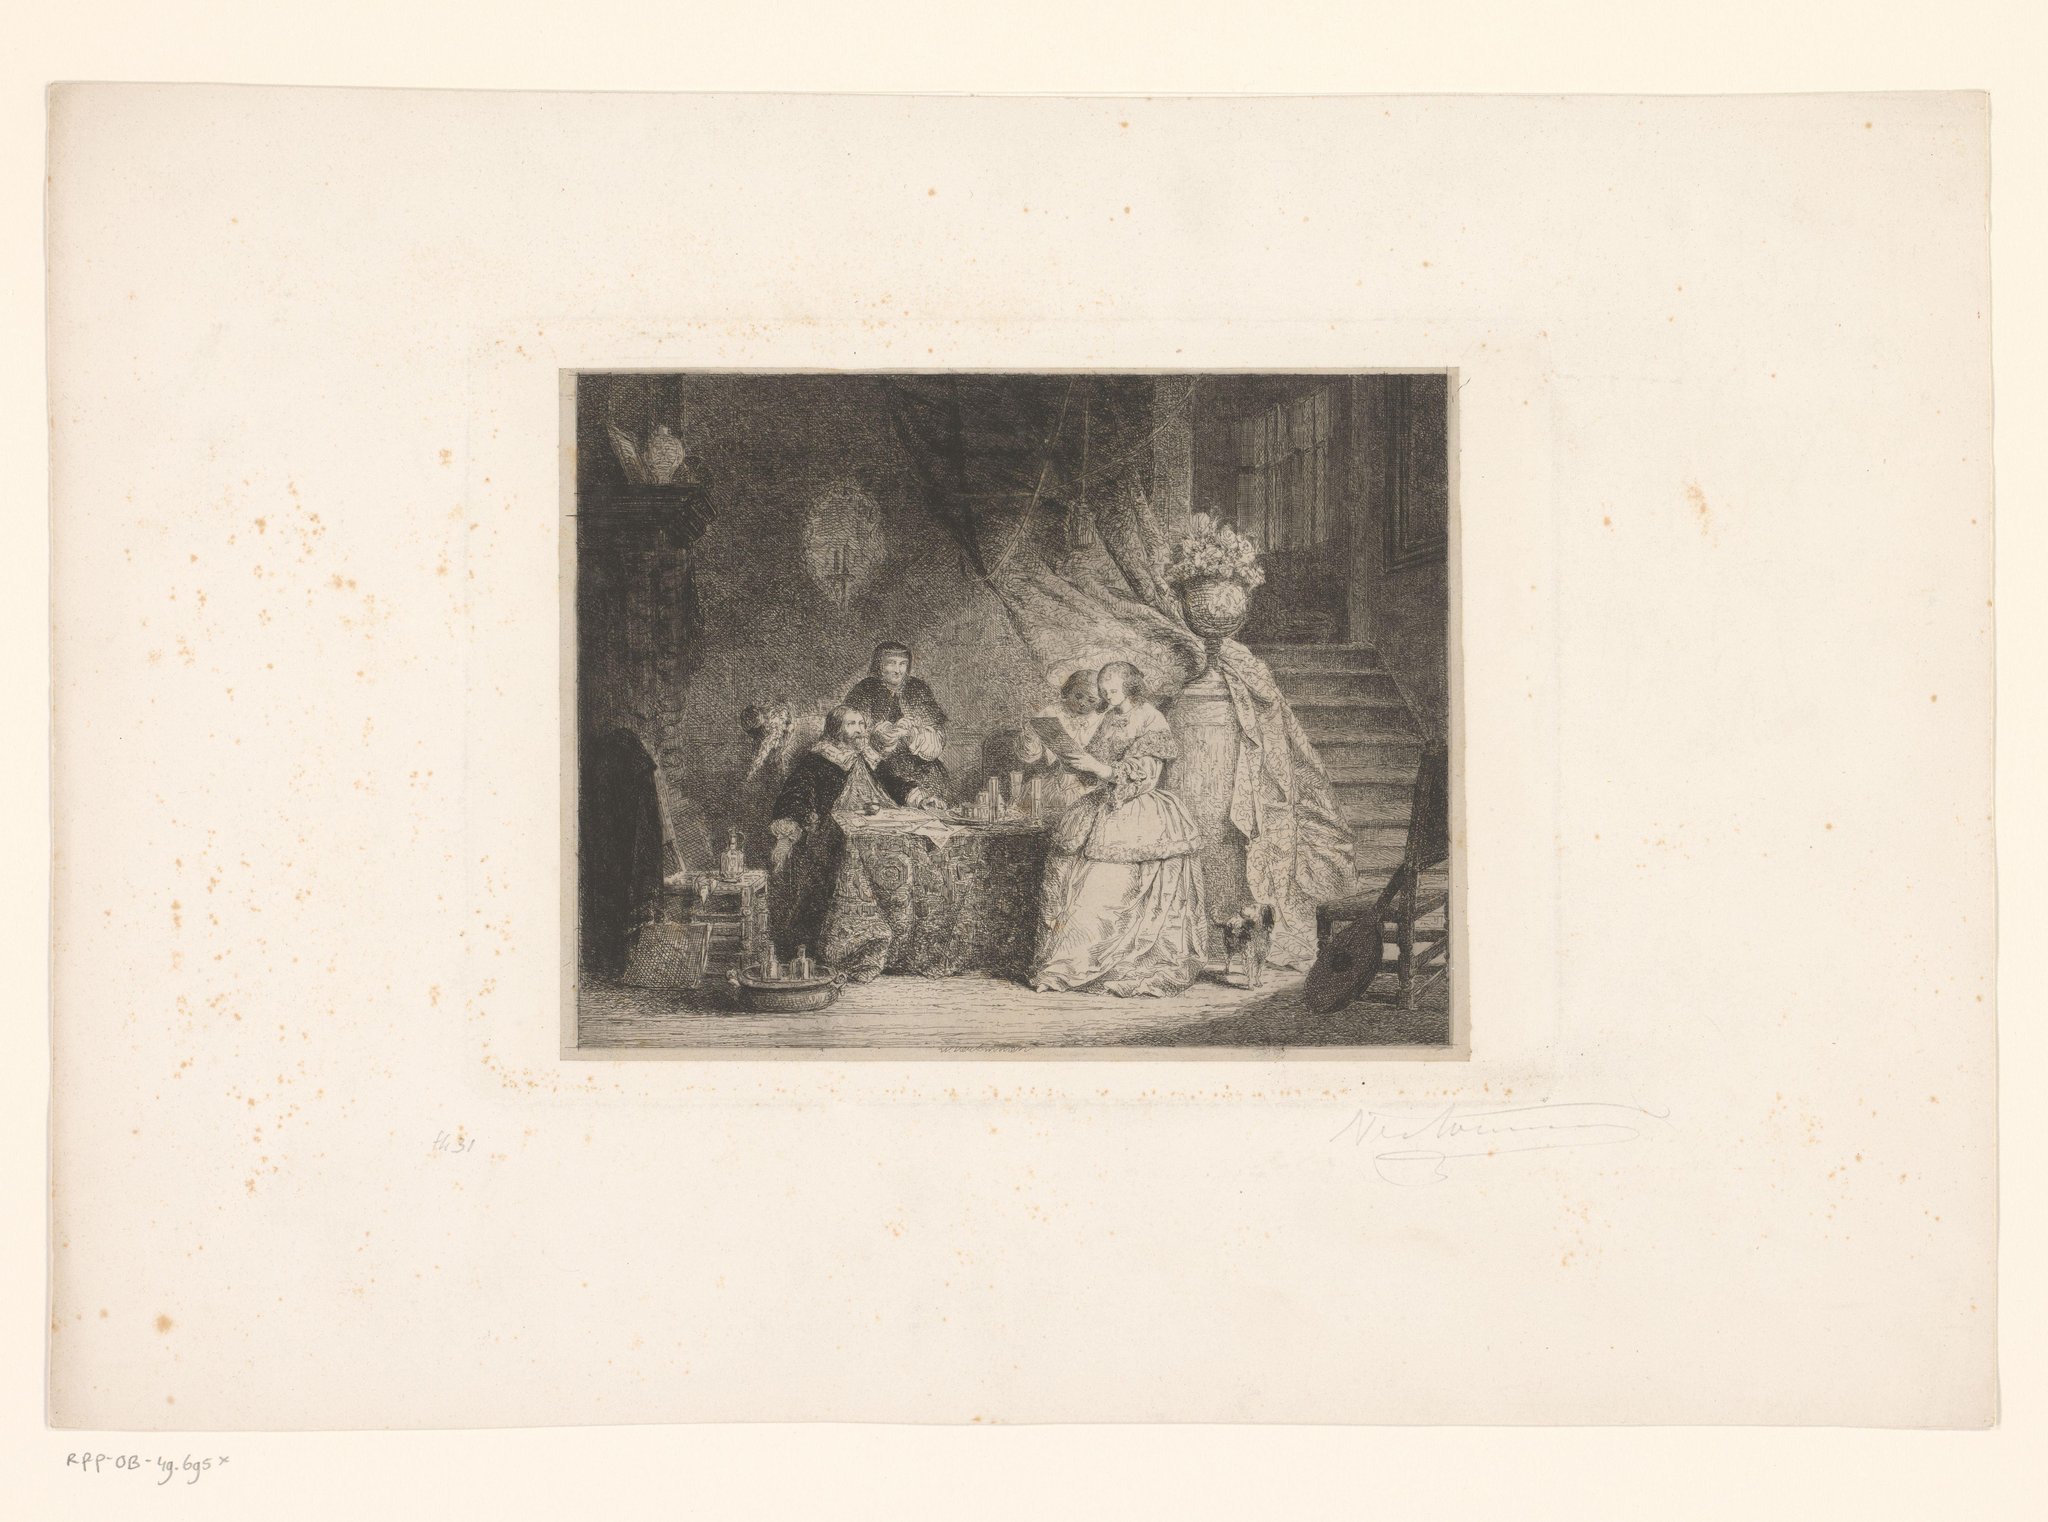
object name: print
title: Interieur met twee jonge vrouwen die een ontwerp bekijken van de kunstenaar die aan tafel zit naast een staande vrouw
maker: guillaume joseph vertommen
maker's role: print maker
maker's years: 1815-1863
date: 1825-1863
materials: paper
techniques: etching, intaglio, roulette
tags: artist (in general) working from live model, interior of the house, artist (in general) making preliminary designs, sketching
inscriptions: collector's mark: Lugt 2228